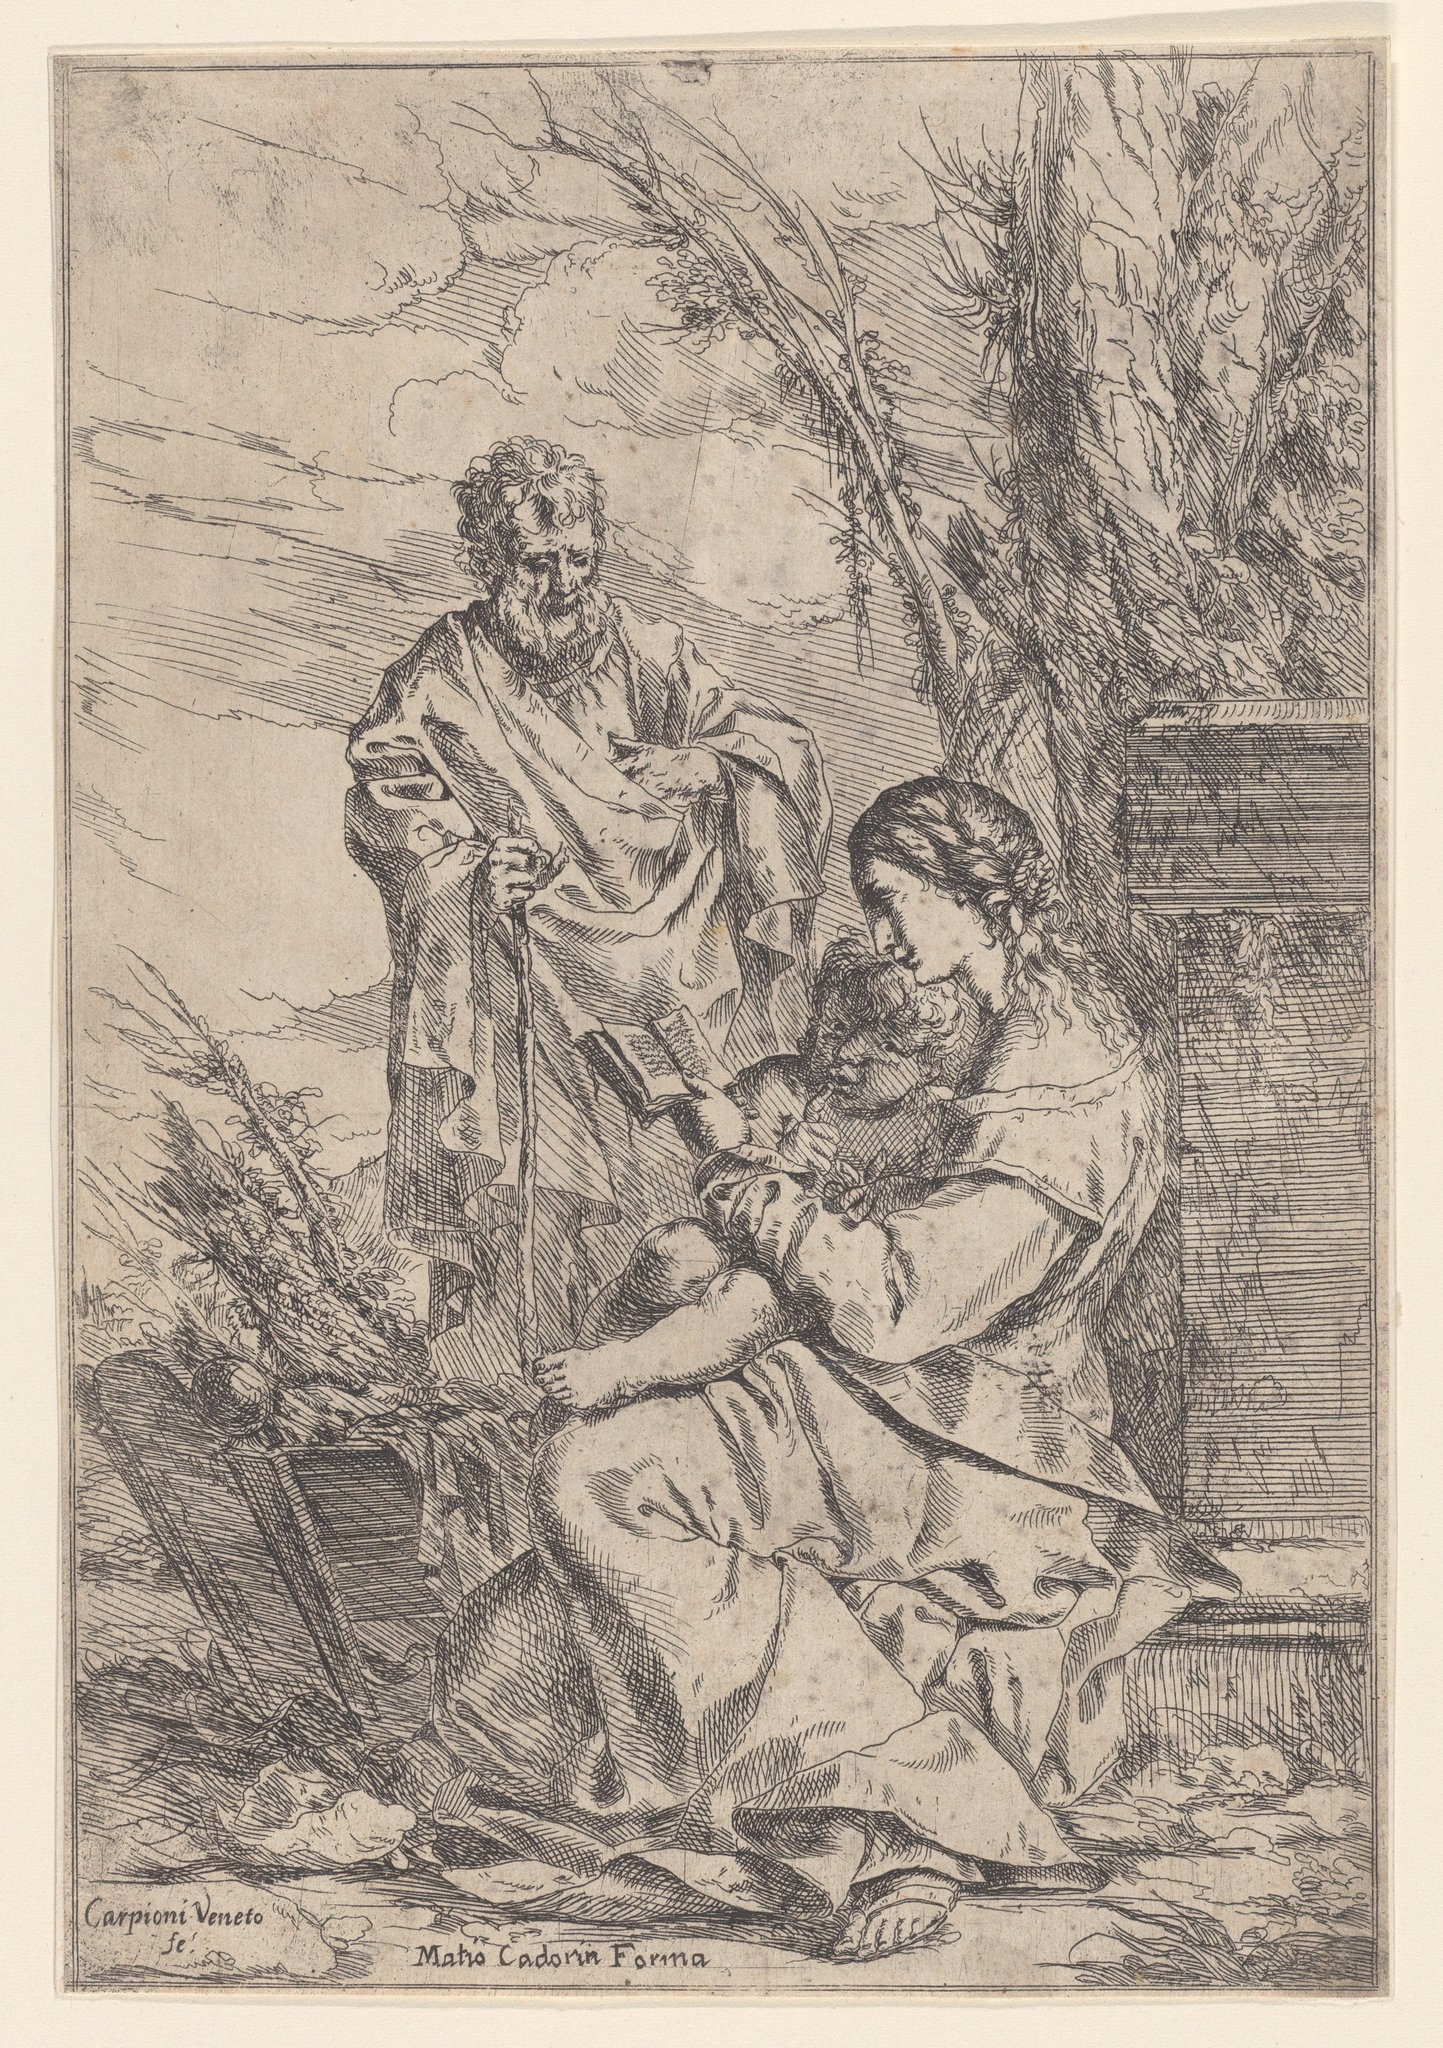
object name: print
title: The Holy Family with the Virgin reading a book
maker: giulio carpioni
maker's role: artist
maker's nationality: italian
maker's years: 1613-1678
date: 1640-1660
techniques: etching